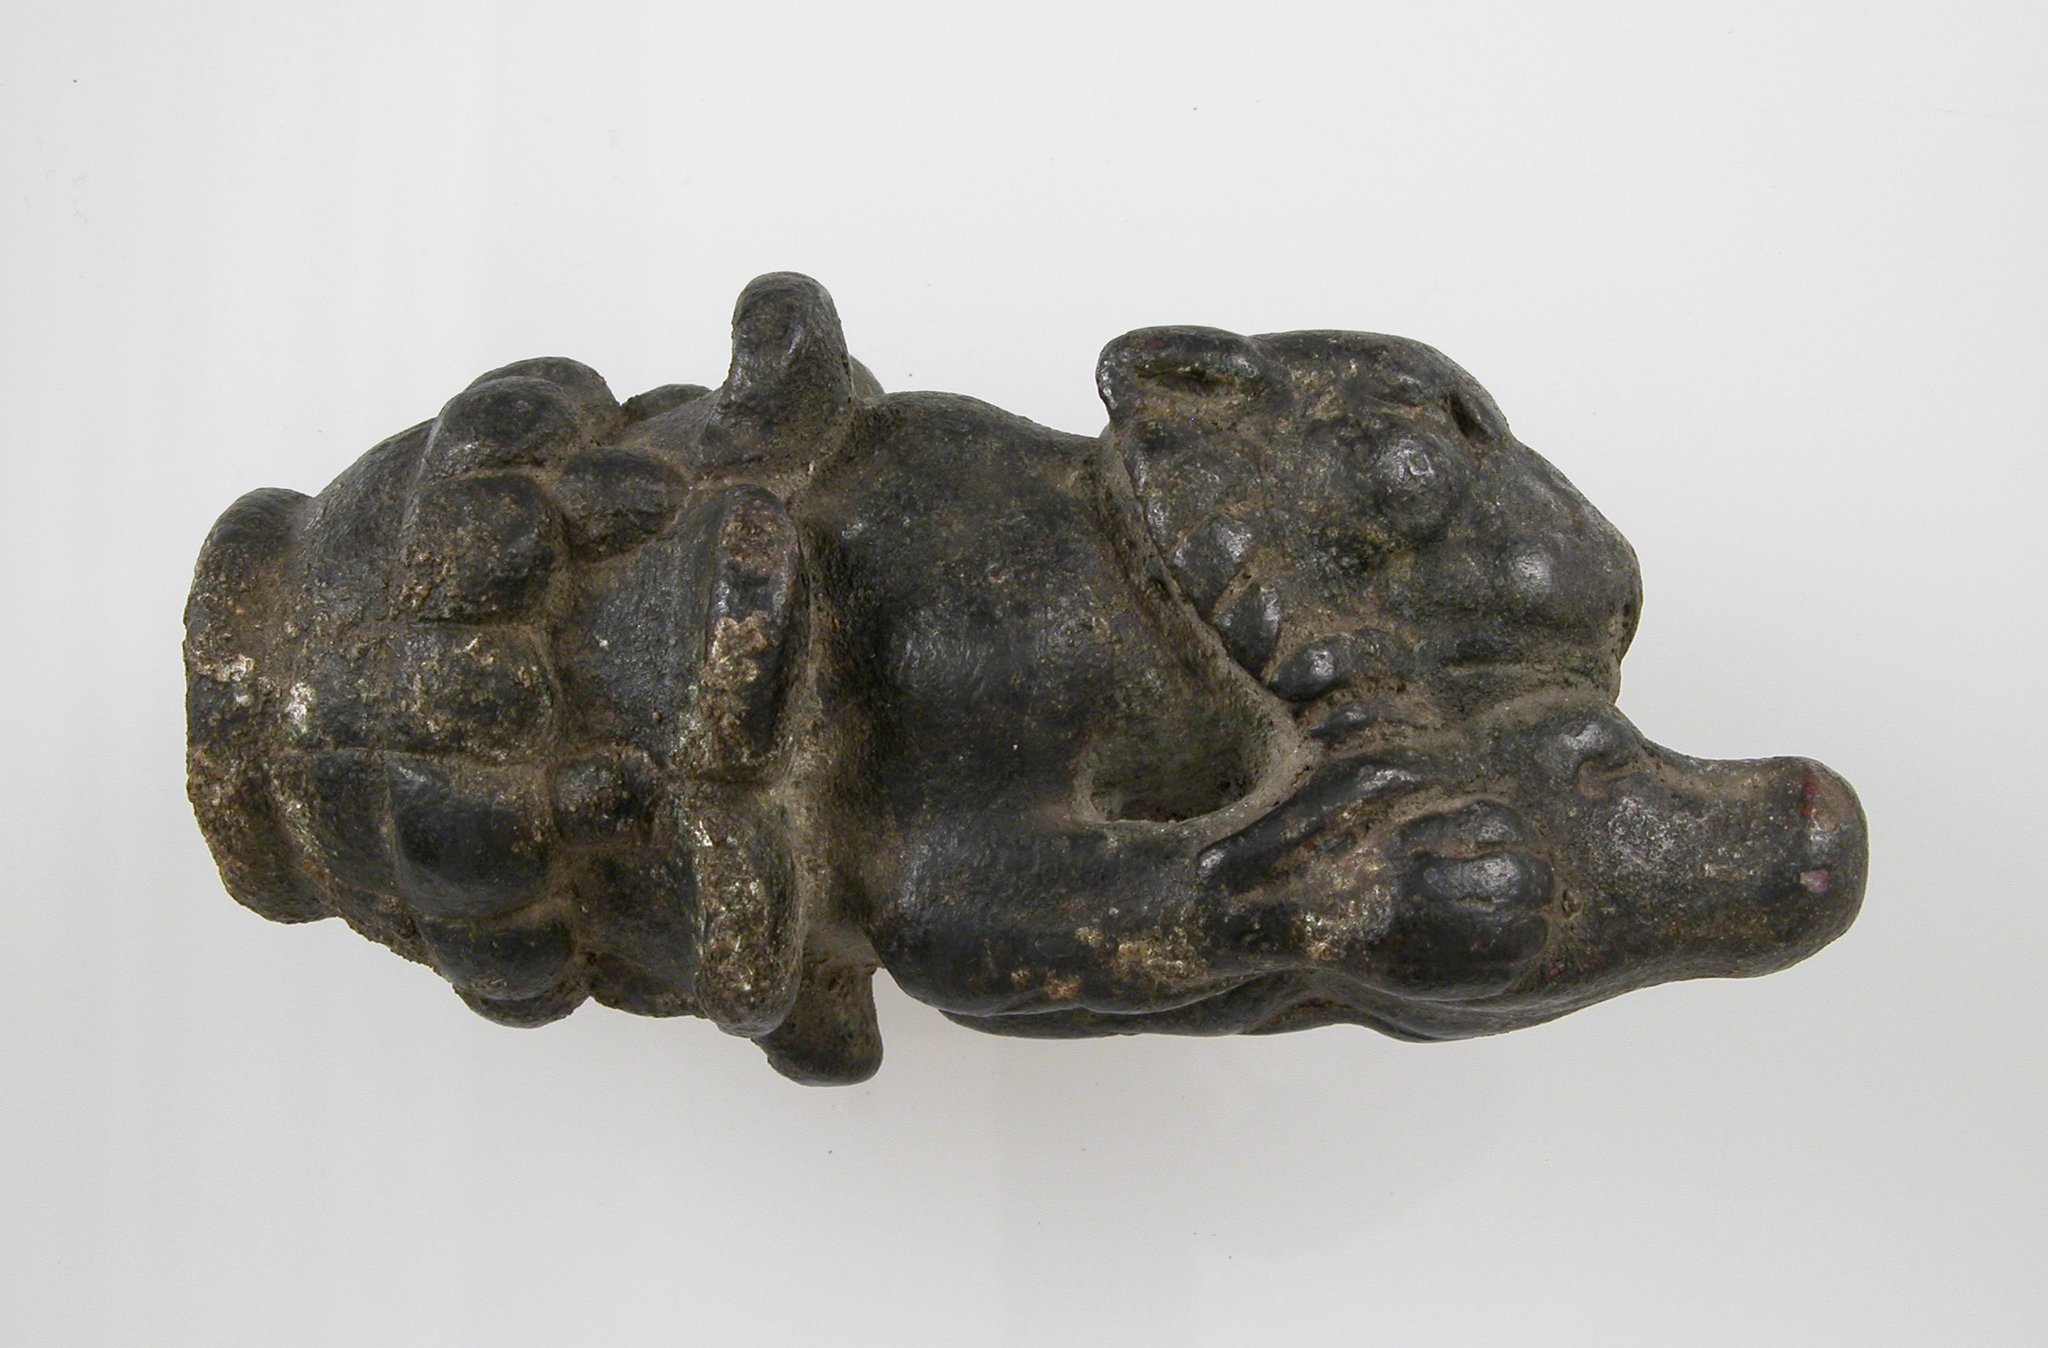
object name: key handle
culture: roman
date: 1-700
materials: copper alloy